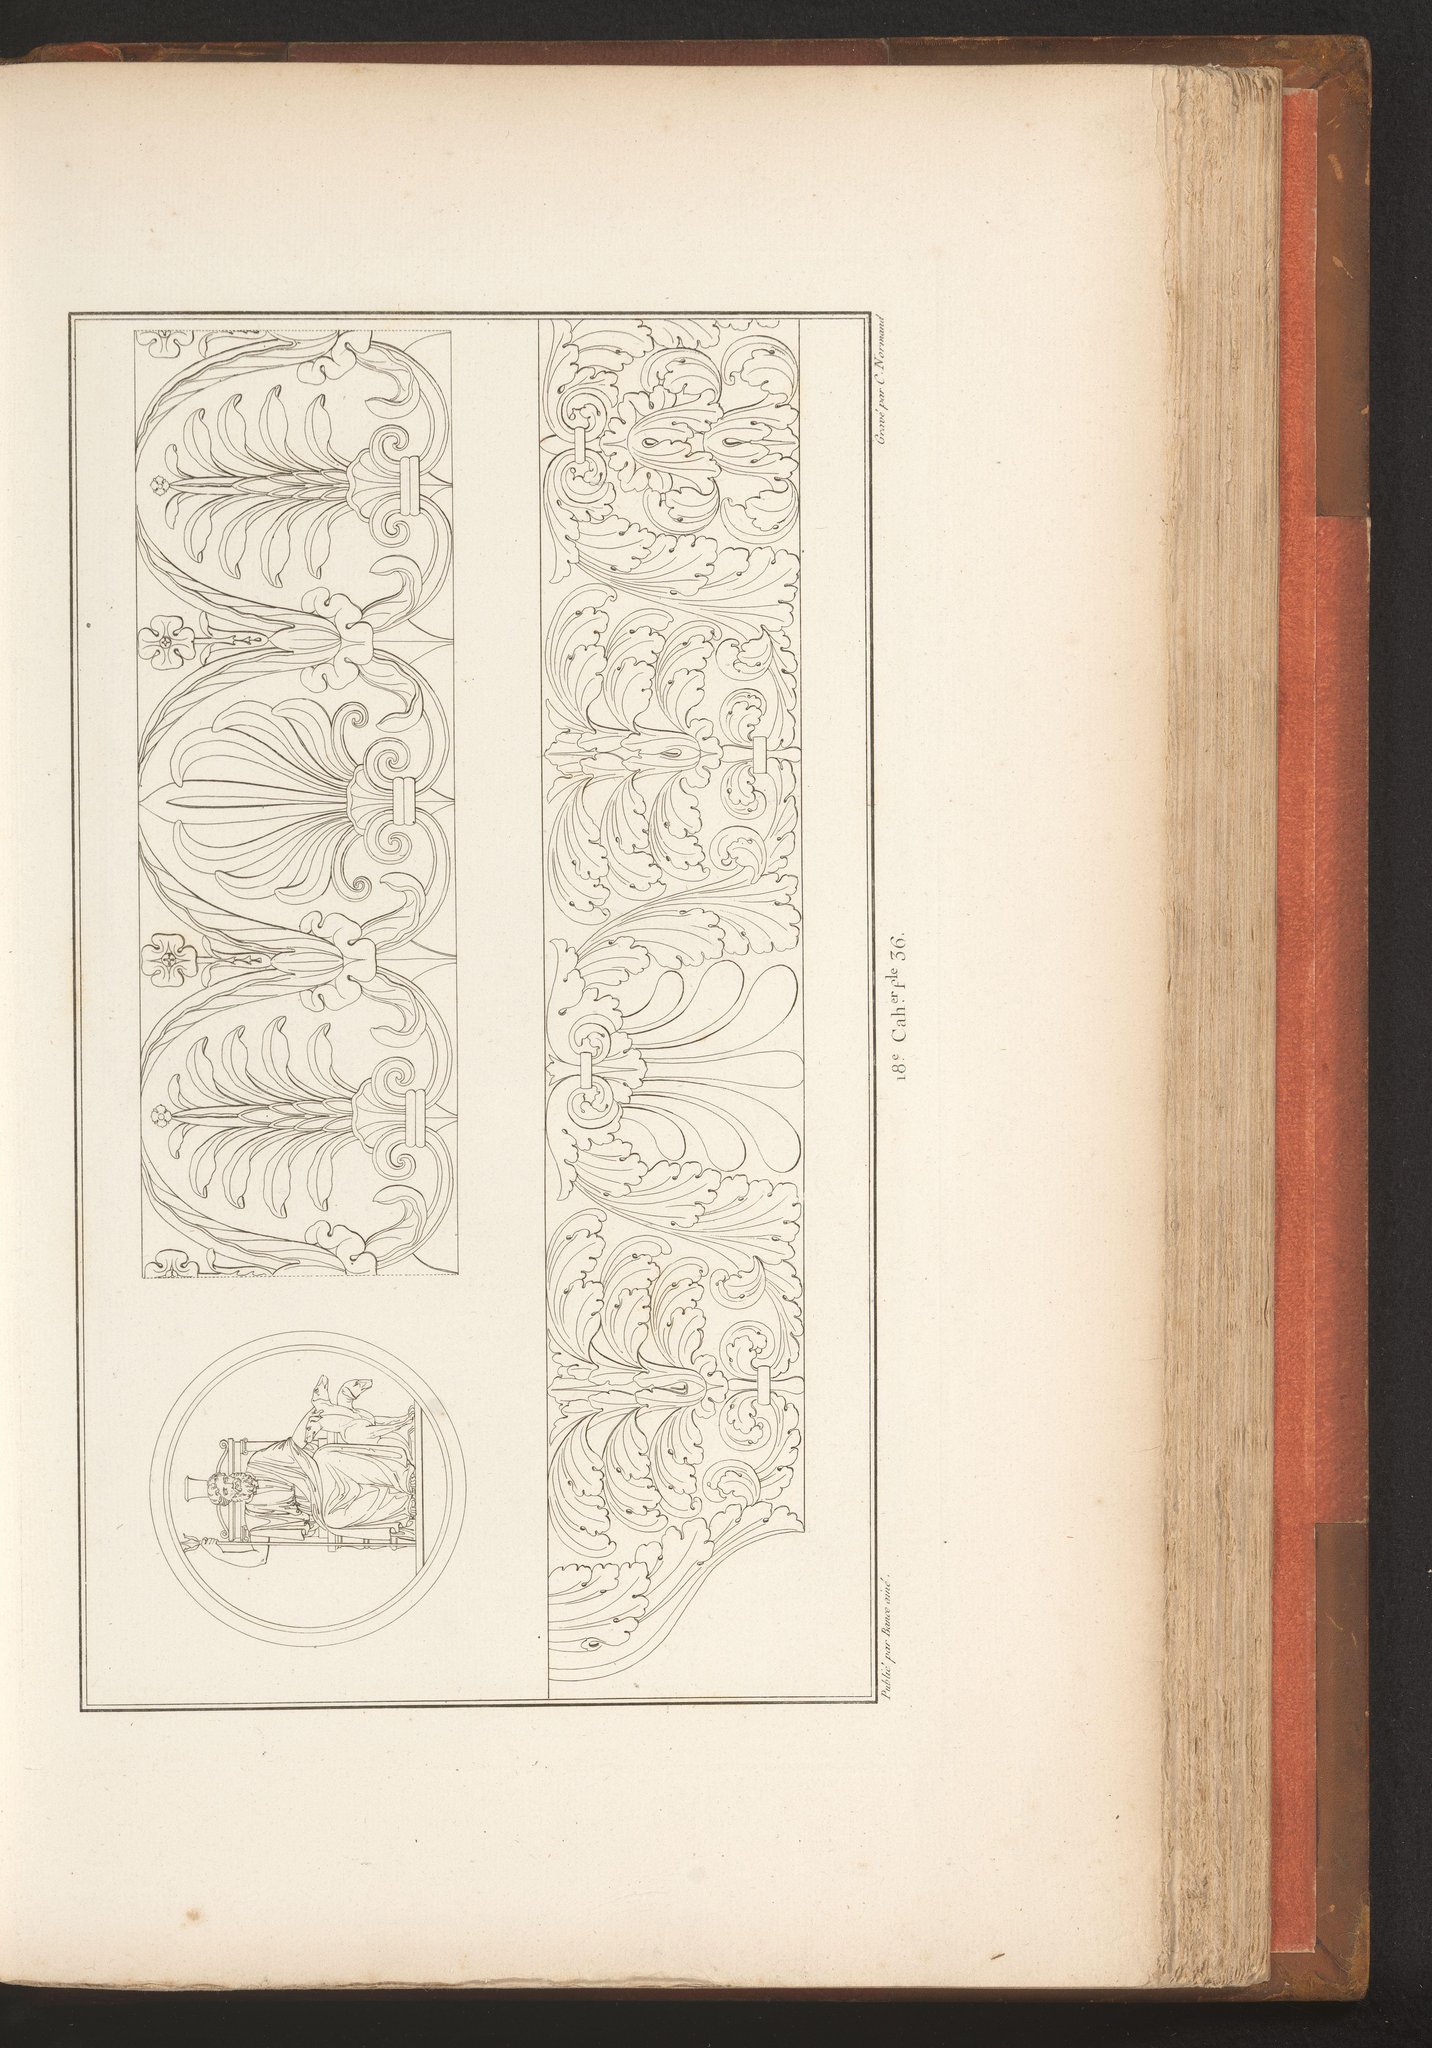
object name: ornament print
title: Twee friezen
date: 1820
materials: paper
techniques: etching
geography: paris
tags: ornament derived from plant forms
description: Ornamentprent met twee friezen. Onderdeel (18e. Cah.er f.le 36) van het prentalbum met twee series van in totaal 138 ornamentprenten door Beauvallet en Normand, 'Fragmens d'Ornemens dans le Style Antique'.